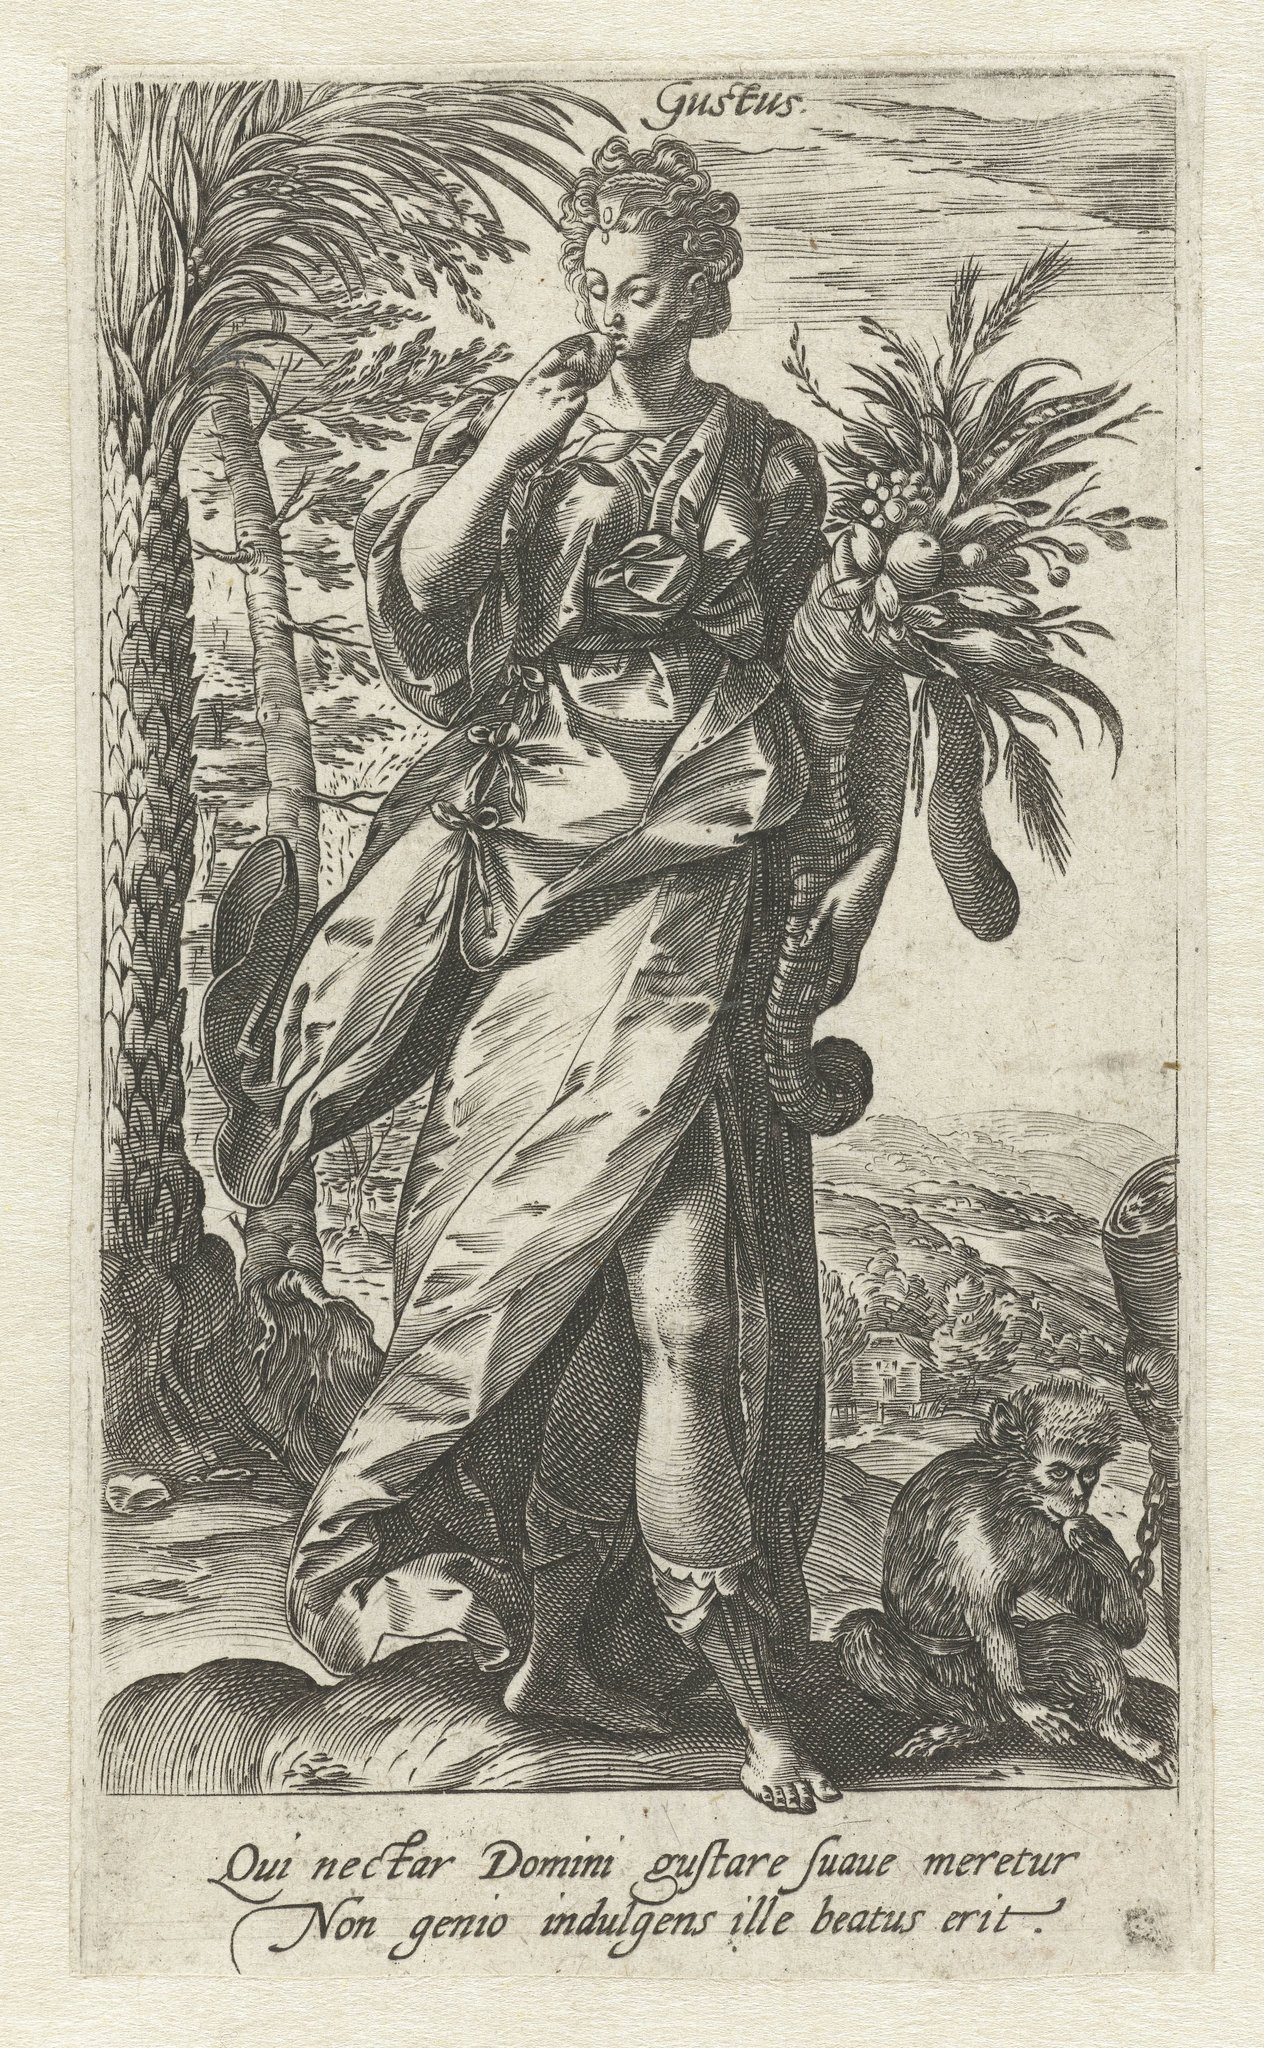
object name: print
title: Smaak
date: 1576-1580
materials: paper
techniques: engraving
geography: antwerp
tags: taste, tasting (one of the five senses)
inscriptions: collector's mark: Lugt 240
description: Prent uit een serie van vijf (de vierde in de reeks, maar in tegenstelling tot de andere prenten niet genummerd). Op elk blad is een personificatie te zien van een van de vijf zintuigen. Onder elke prent uit deze serie twee regels Latijn.